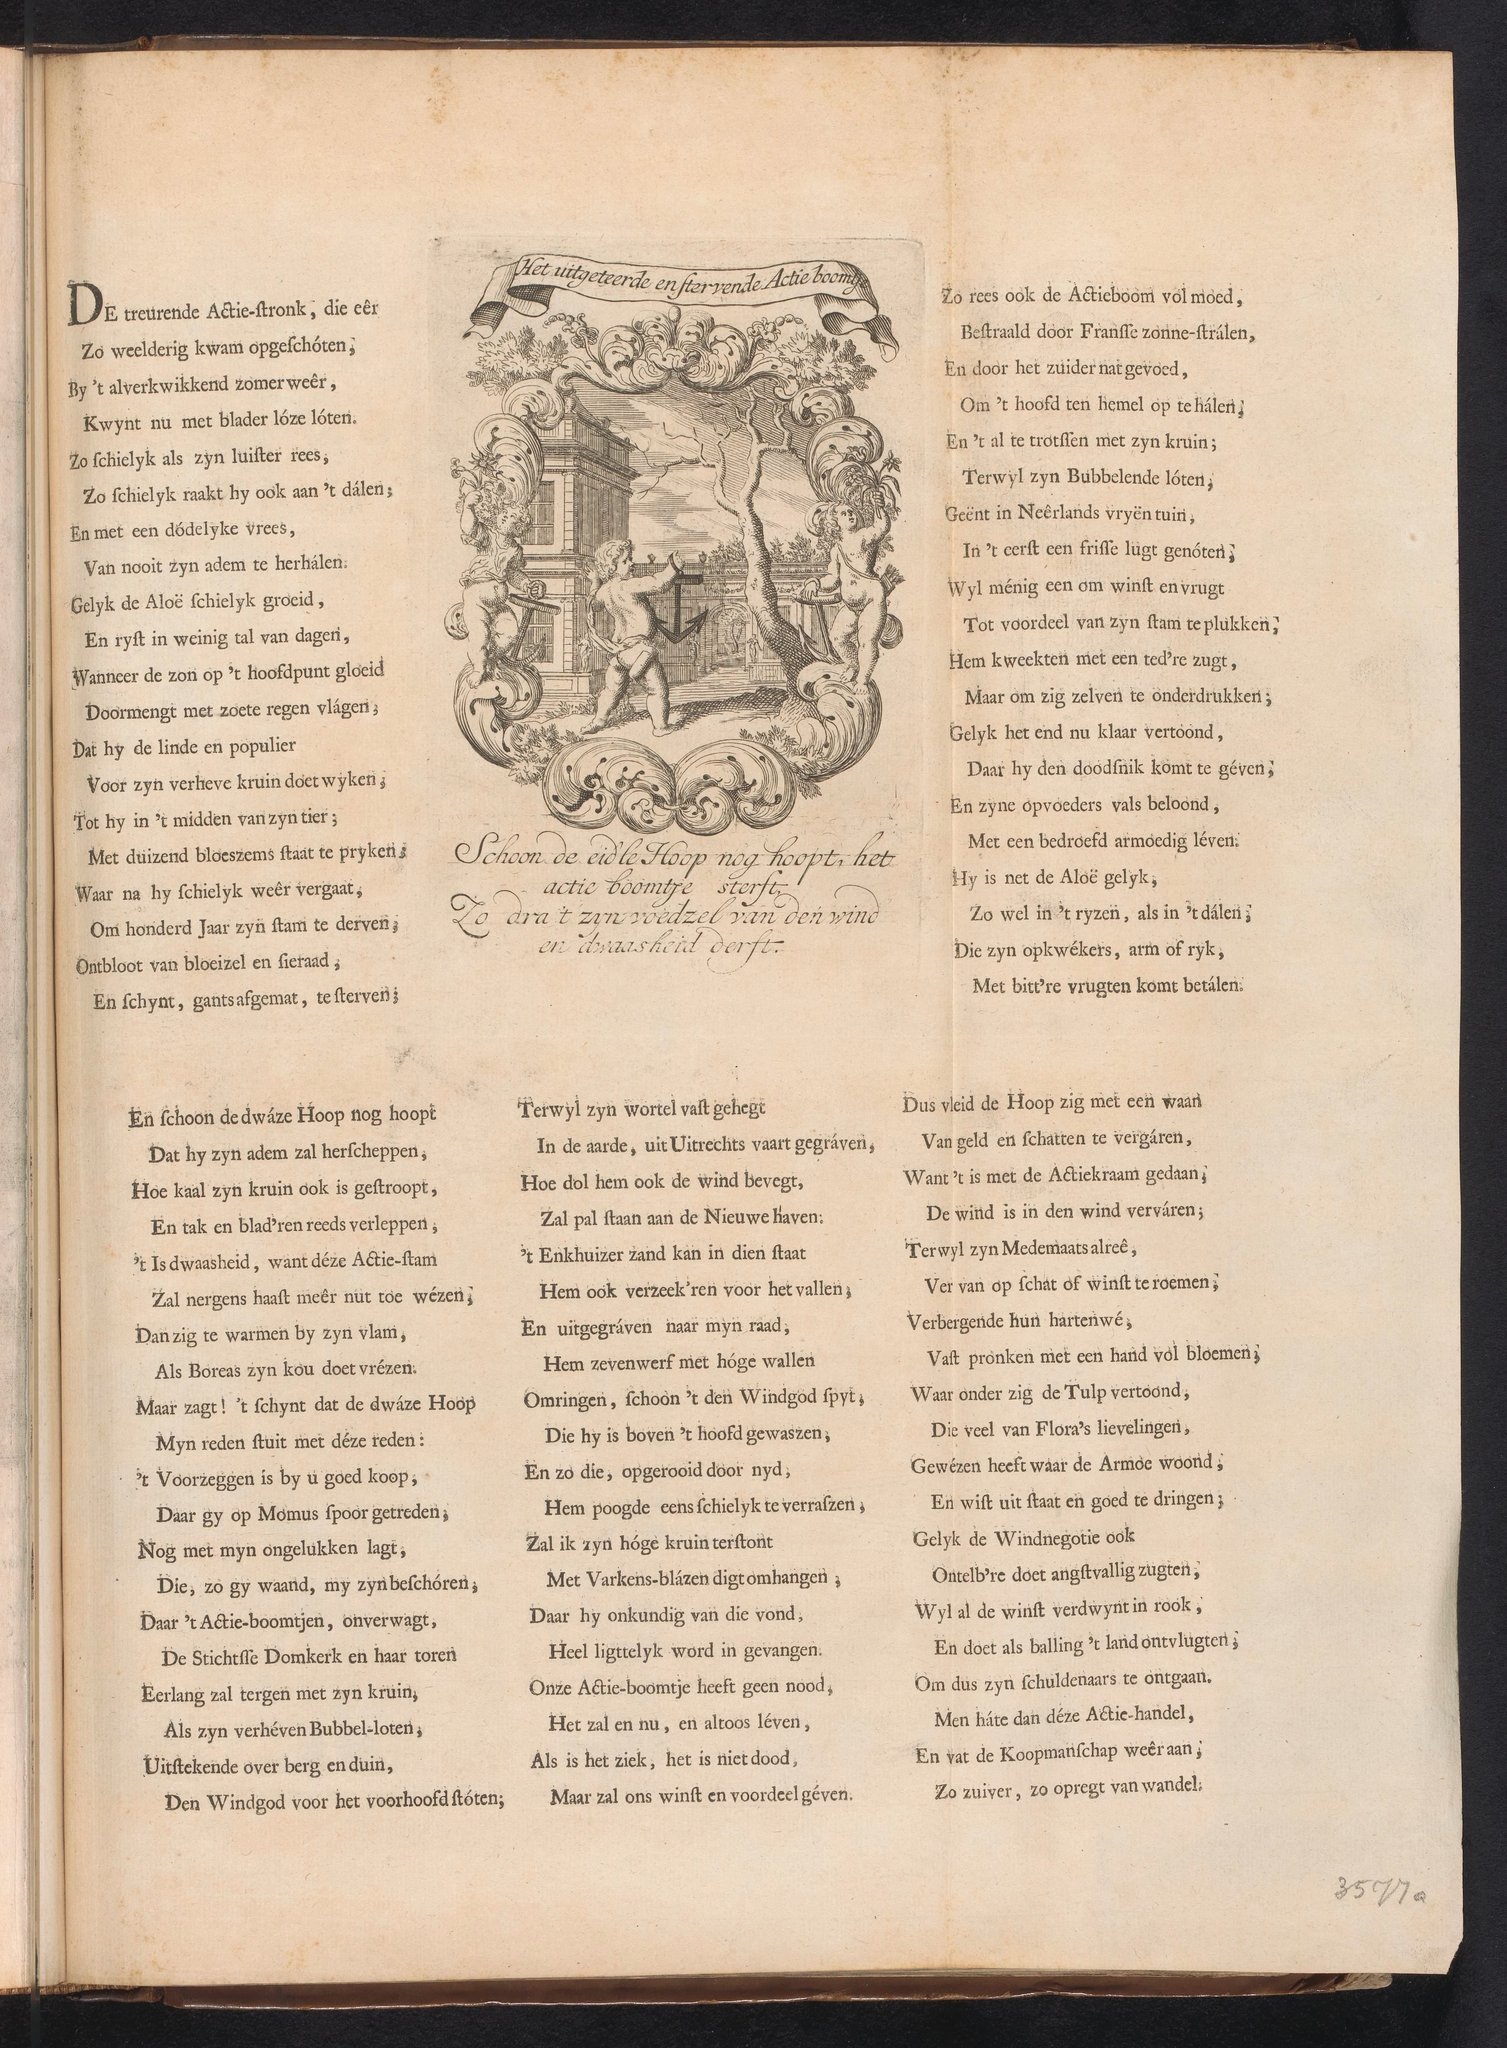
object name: print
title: Het Groote Tafereel der Dwaasheid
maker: pieter van den berge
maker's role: draughtsman, print maker, printer, publisher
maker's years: 1659-1737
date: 1697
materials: paper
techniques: engraving, etching, letterpress printing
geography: northern netherlands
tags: hope; 'speranza', 'speranza delle fatiche' (ripa), trees (+ plants used symbolically)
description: Het verdorde en stervende actieboompje. De Hoop bij een verdorde boom. In een decoratieve omlijsting met personificaties van de Hoop met ankers en bloemen. In het onderschrift een vers van vier regels. Gedrukt op het blad om en onder de plaat staan vijf verzen. Prent in de gebonden eerste uitgave (304 B 11) van Het Groote Tafereel der Dwaasheid met spotprenten op de Windhandel of Actiehandel van 1720.